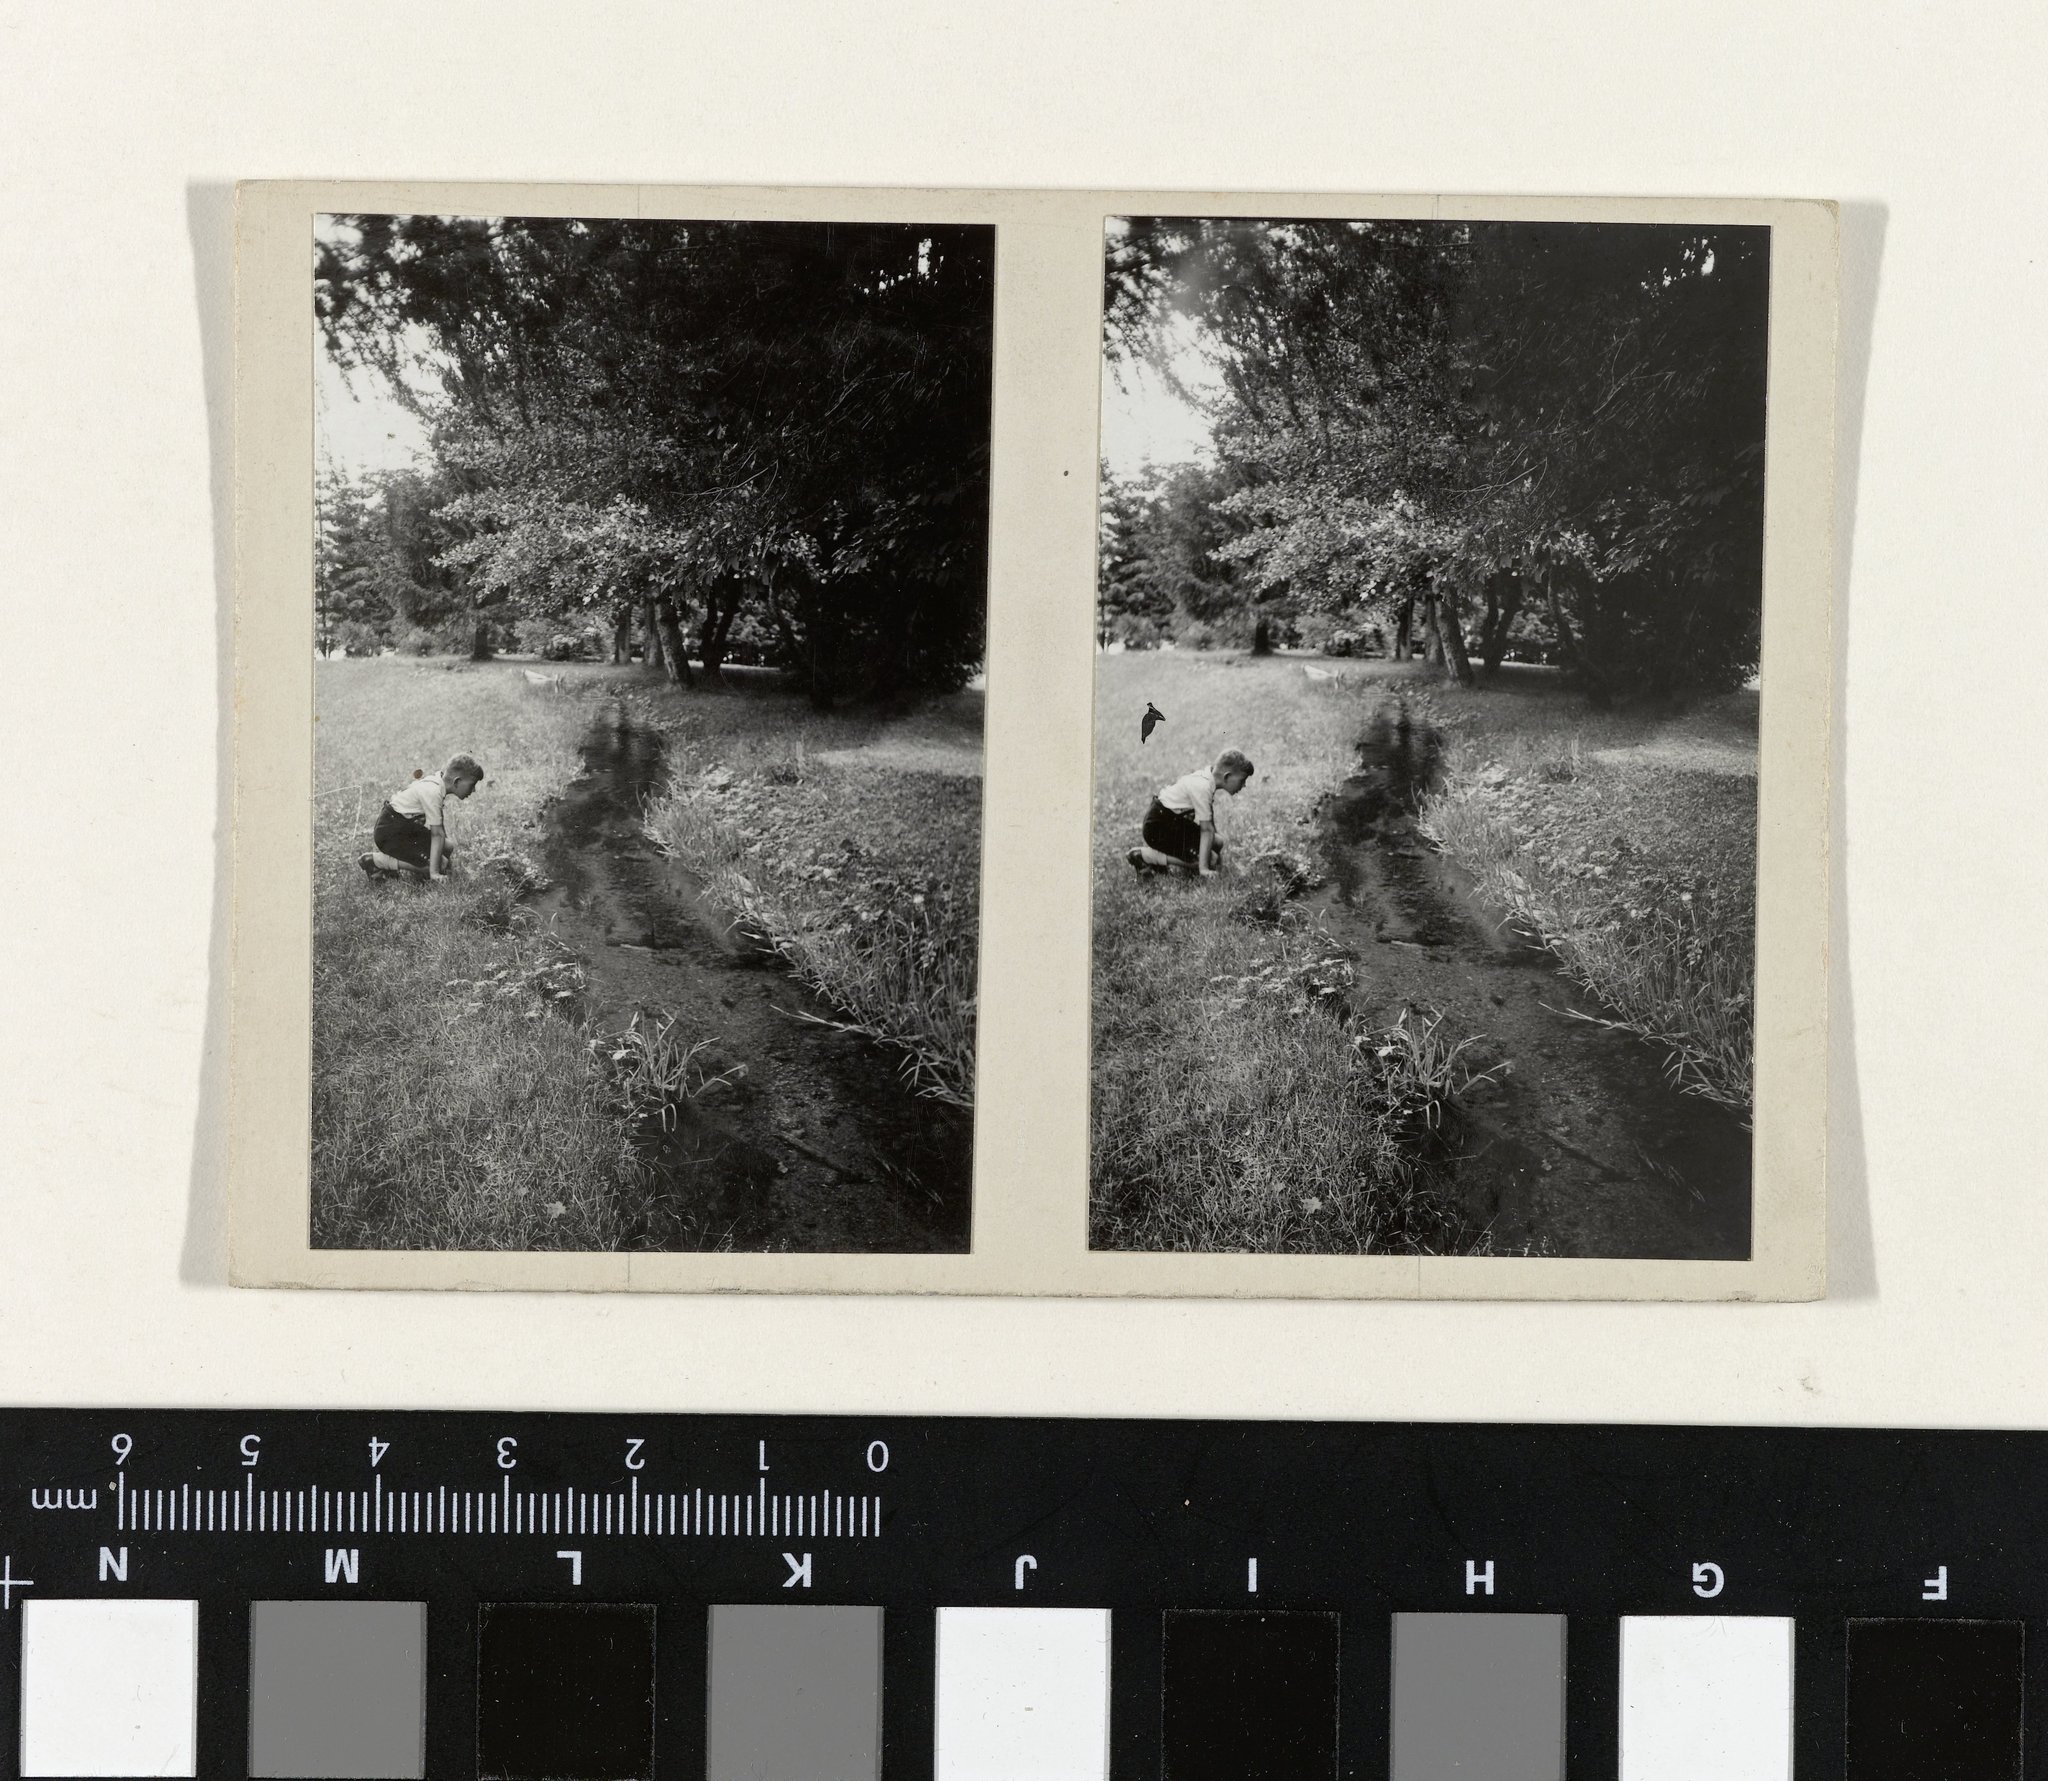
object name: stereograph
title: Jan bij het hotel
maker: geldolph adriaan kessler (dolph)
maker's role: fotograaf, industrieel, voetballer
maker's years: 1884-1945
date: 1920-1945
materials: paper, photographic support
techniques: collodion silver print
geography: netherlands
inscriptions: title: ‘Jan bij het hotel’